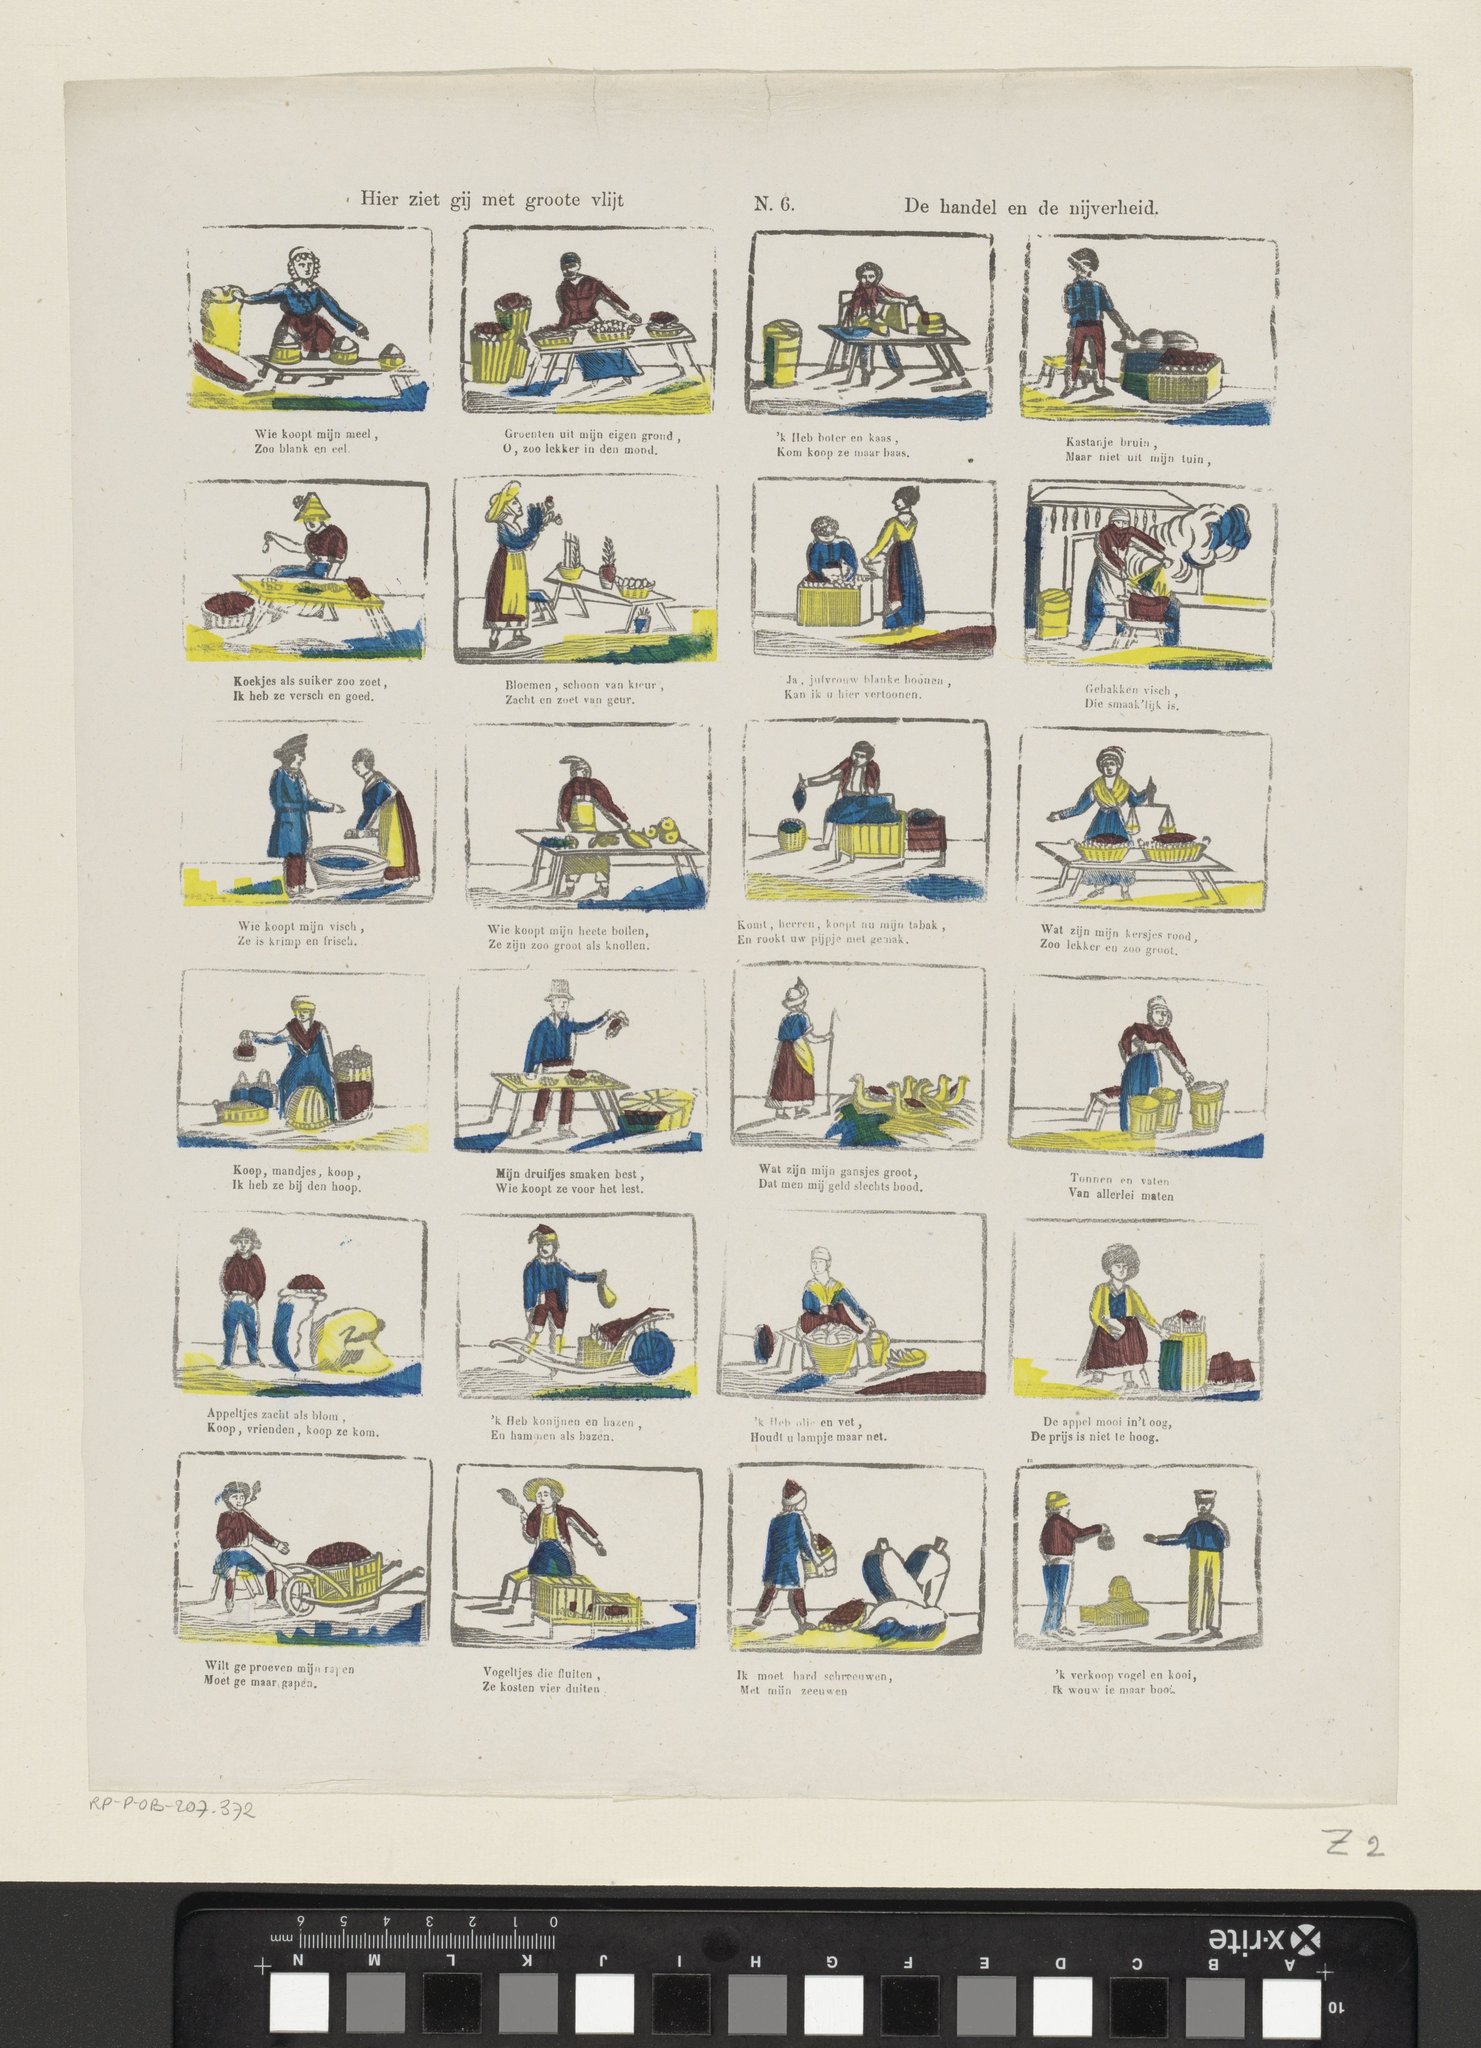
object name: popular print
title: Hier ziet gij met groote vlijt, / De handel en de nijverheid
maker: Anonymous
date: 1848-1881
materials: paper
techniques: colour, letterpress printing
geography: den bosch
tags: street-trader, merchant, salesman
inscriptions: collector's mark: Lugt 2760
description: Blad met 24 voorstellingen van straatverkopers. Onder elke afbeelding een tweeregelig vers. Genummerd midden boven: N. 6.